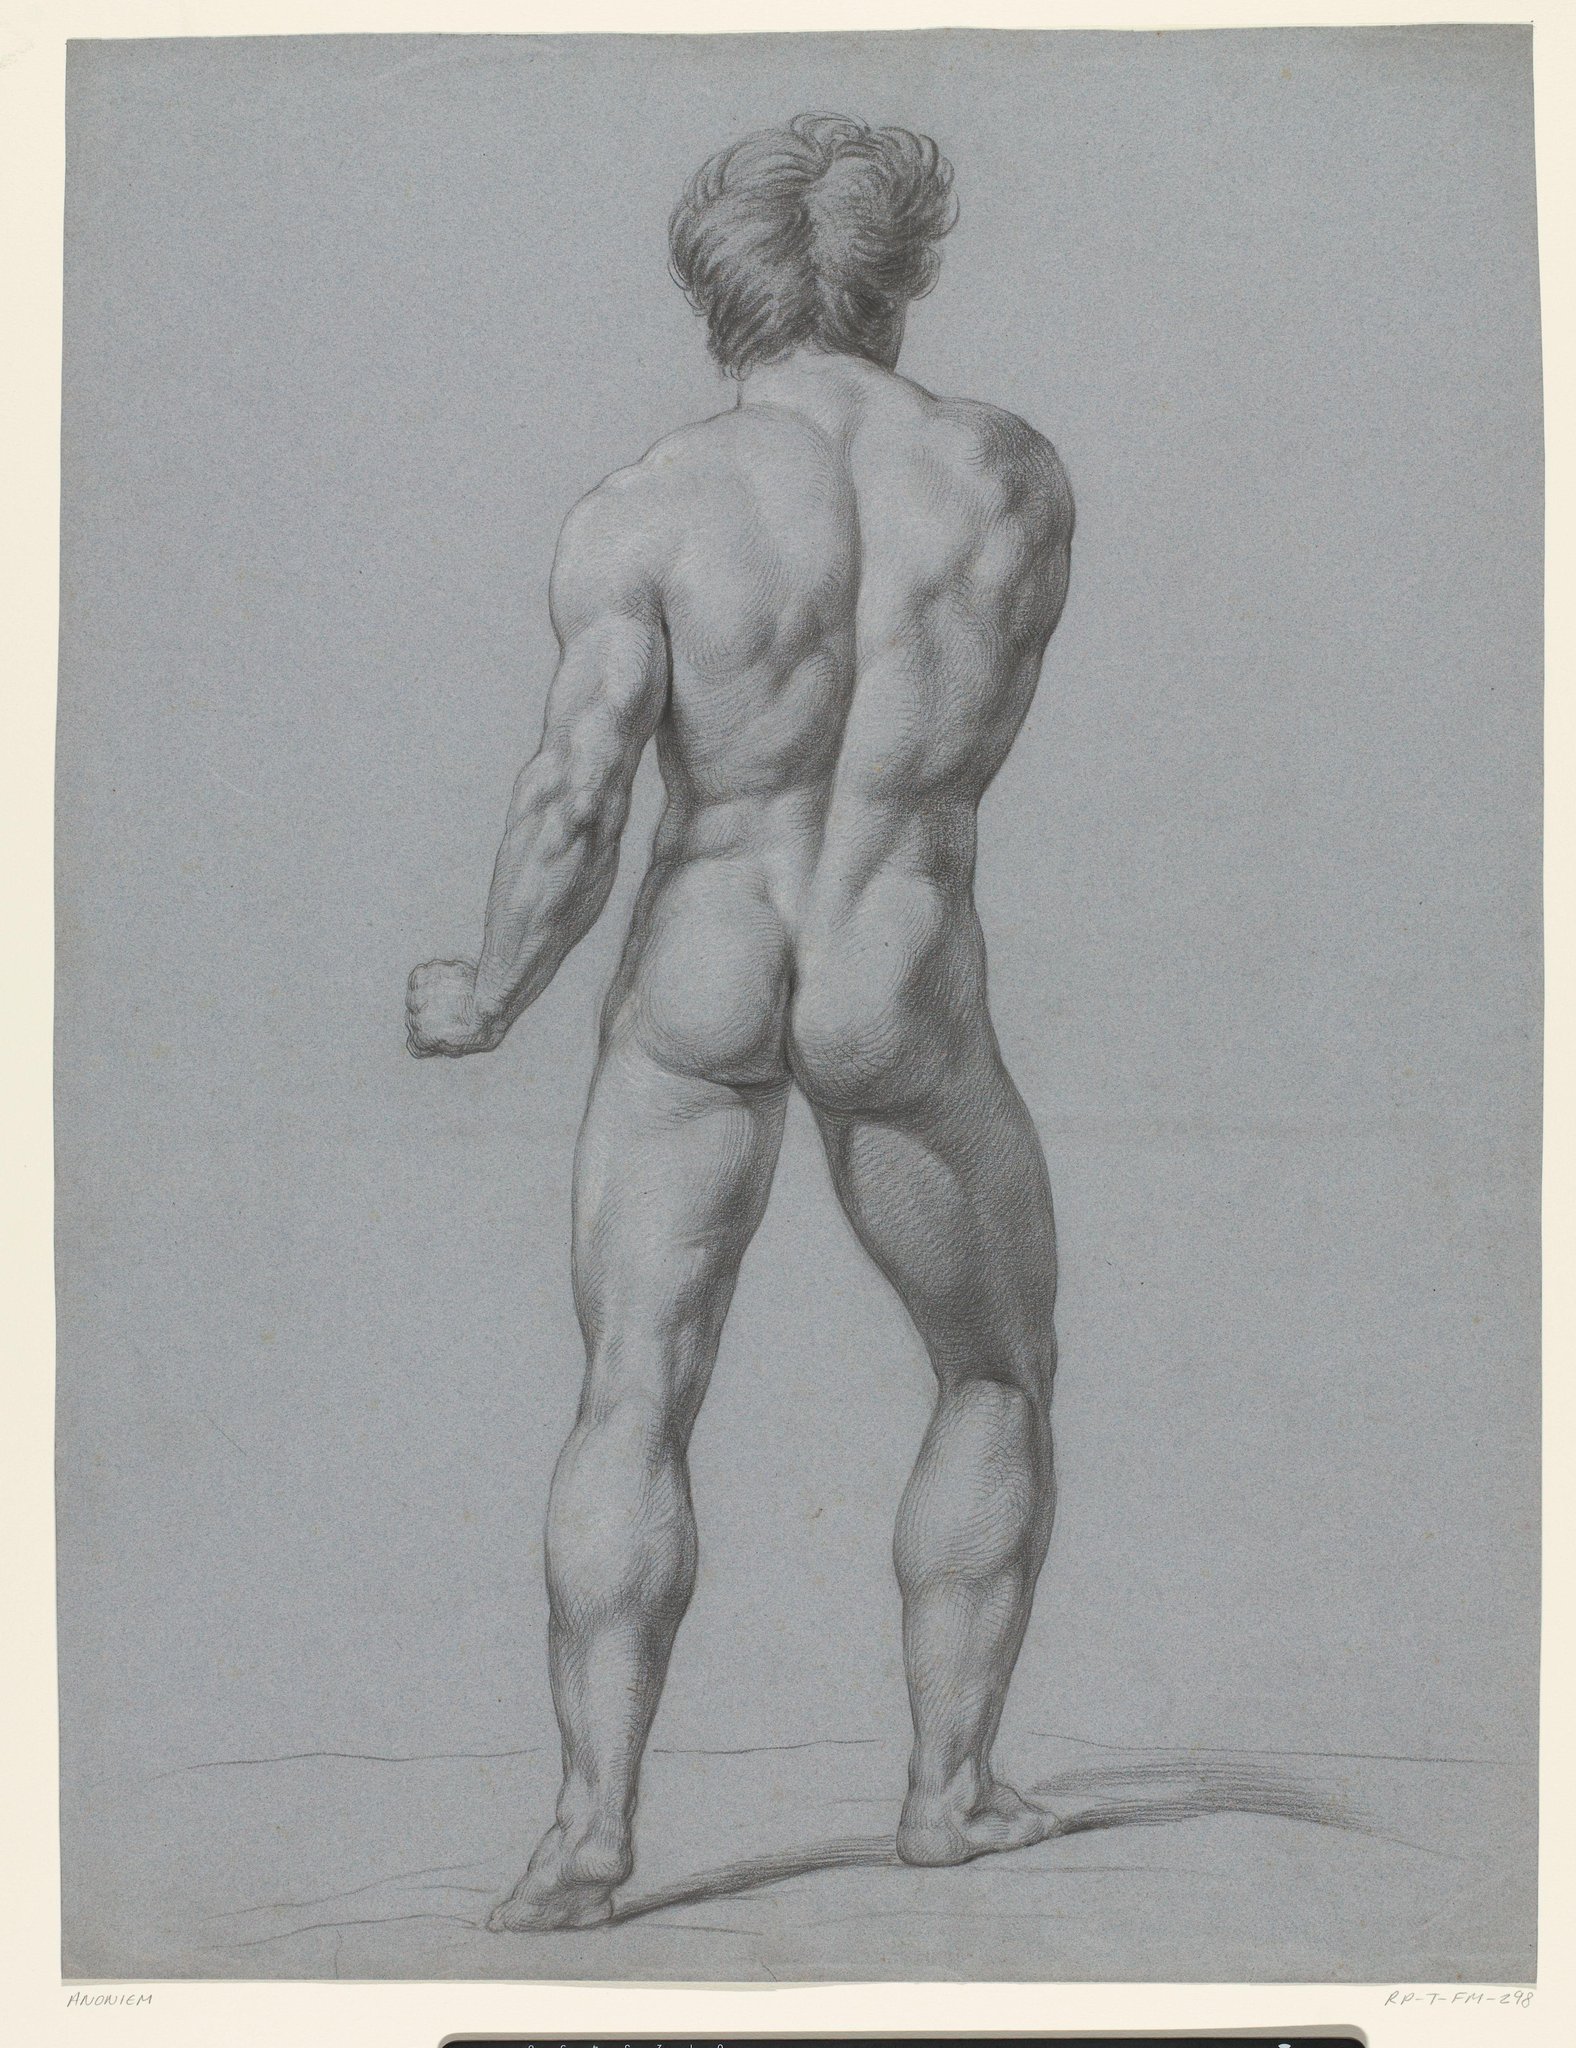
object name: drawing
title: Staand mannelijk naakt, van achteren gezien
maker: Anonymous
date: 1800-1900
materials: chalk, paper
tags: standing figure